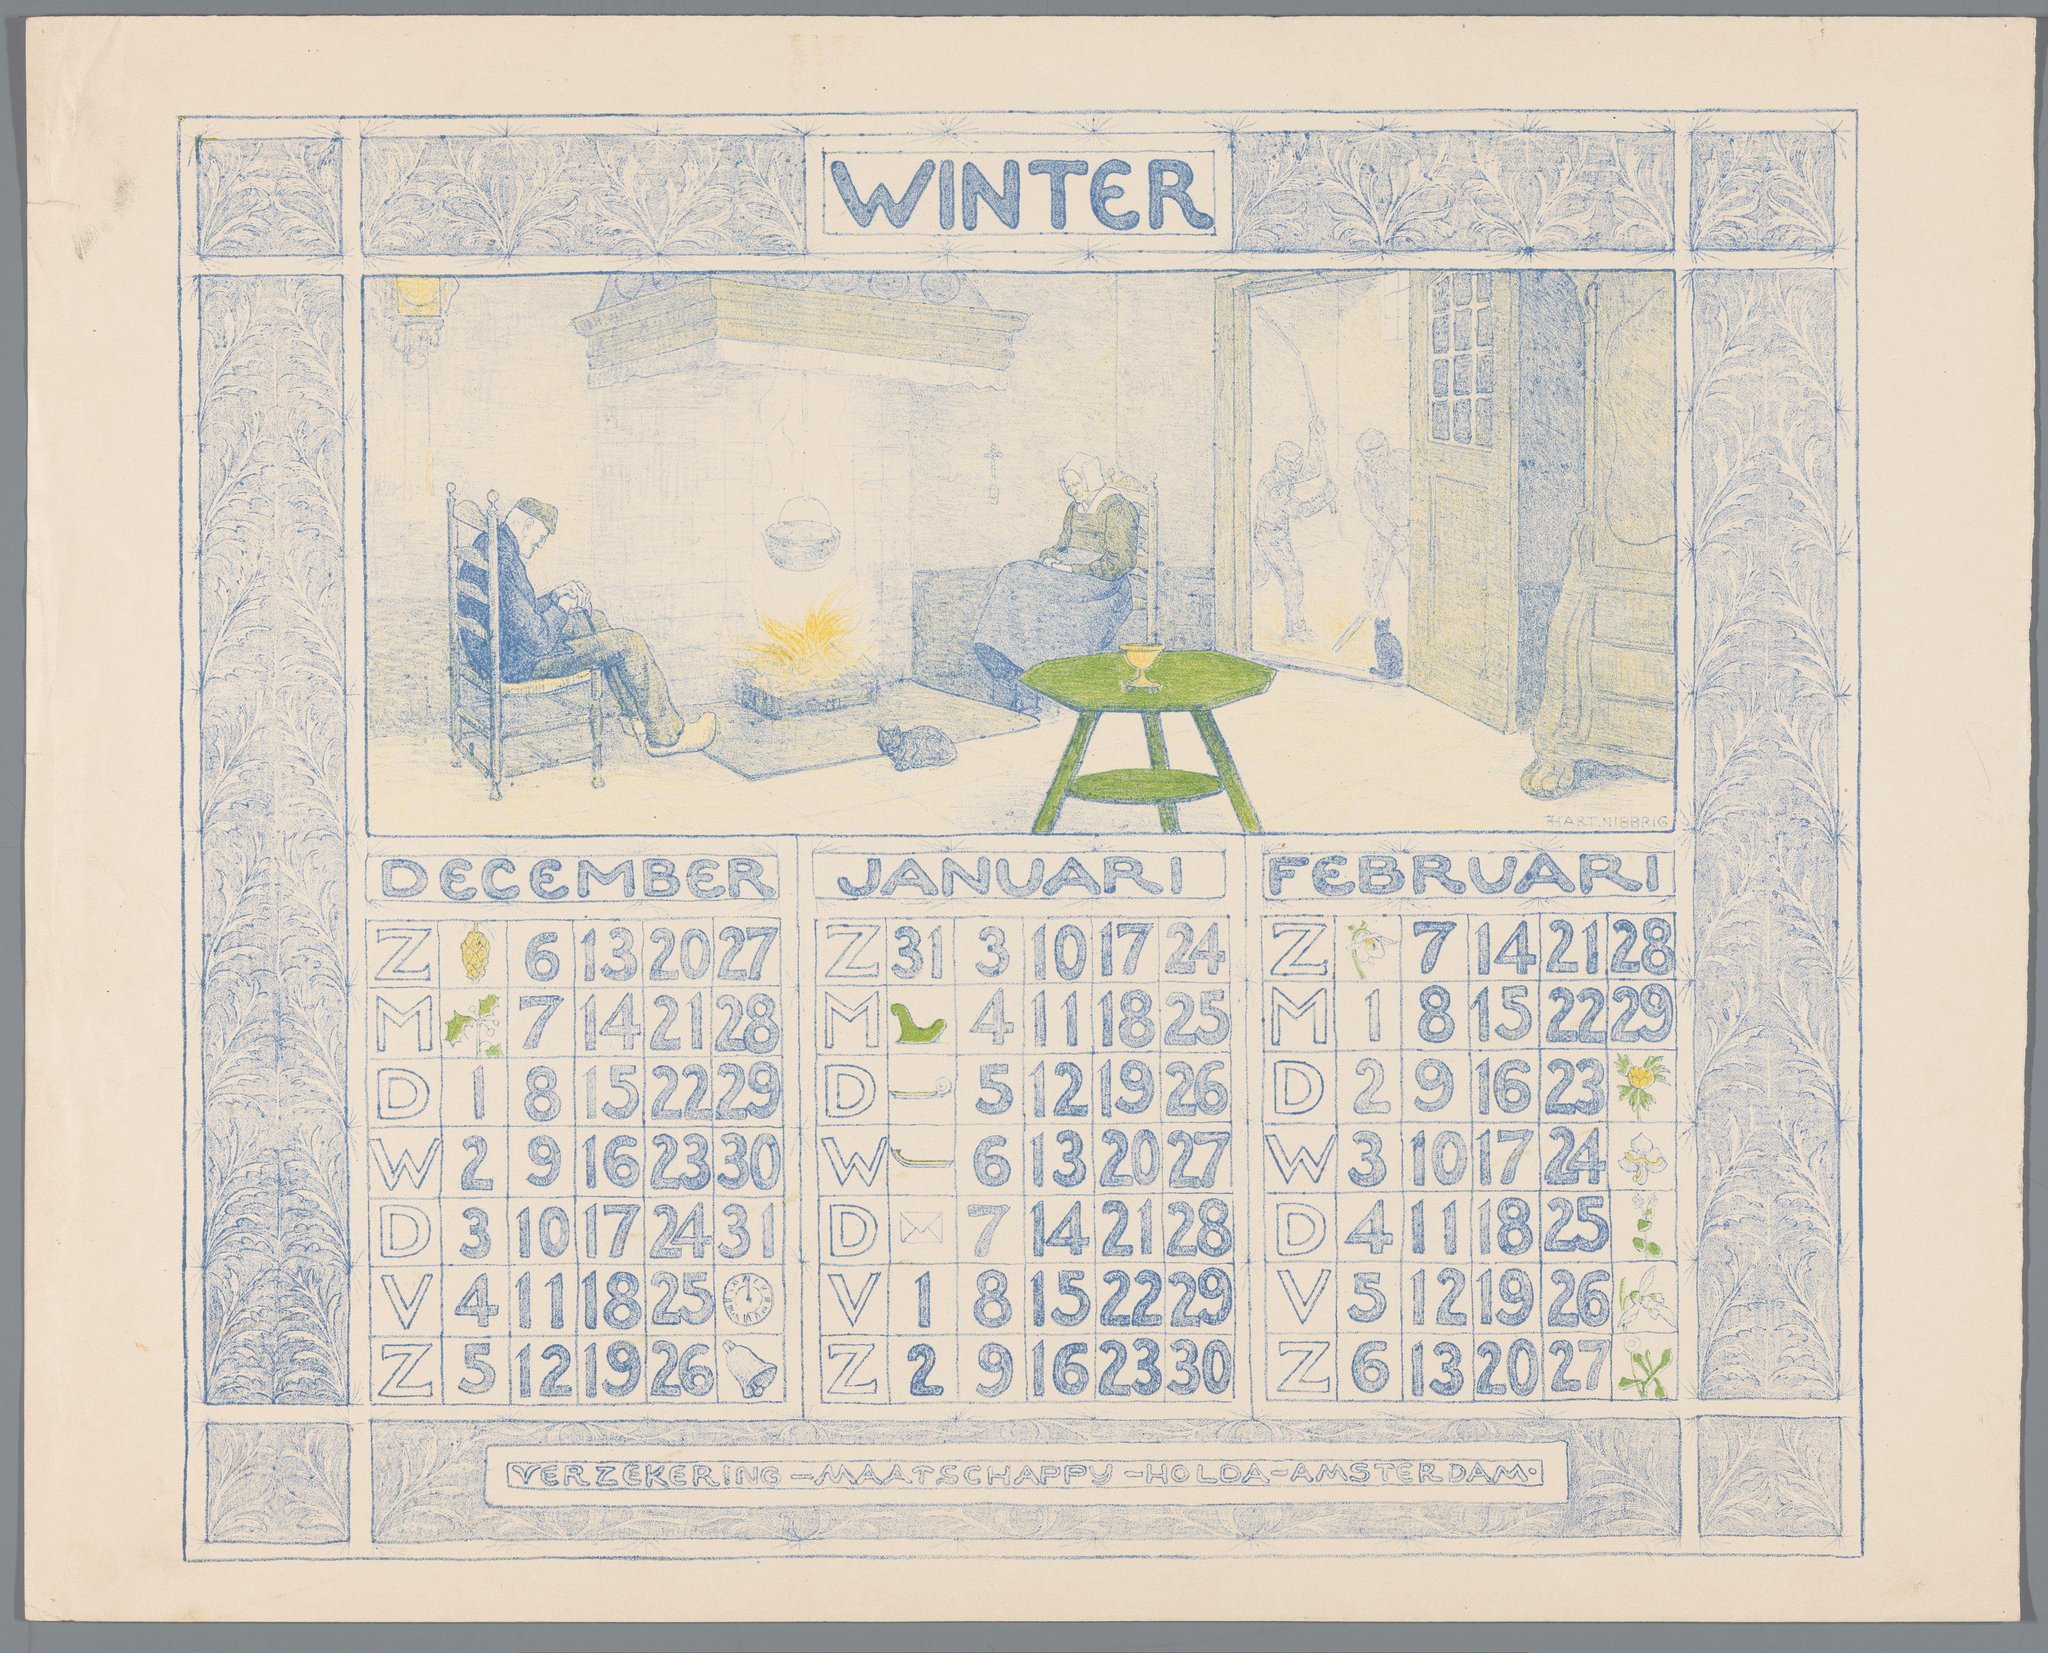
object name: calendar leaf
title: Kalenderblad voor winter 1903-1904 van de Verzekering-Maatschappij Holda in Amsterdam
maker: ferdinand hart nibbrig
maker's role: draughtsman, painter, print maker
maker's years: 1866-1915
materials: paper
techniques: lithograph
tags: cat, open hearth, fire-place, farmers, winter ~ human activities (the four seasons of the year)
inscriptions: collector's mark: Lugt 2228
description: Een rechthoekig kader opgevuld met de dagen van de maanden december, januari en februari en daarboven een boer en boerin, zittend bij een haardvuur met één van hun katten. In de deuropening nog een kat, die naar twee mannen kijkt die in een stal aan het werk zijn.